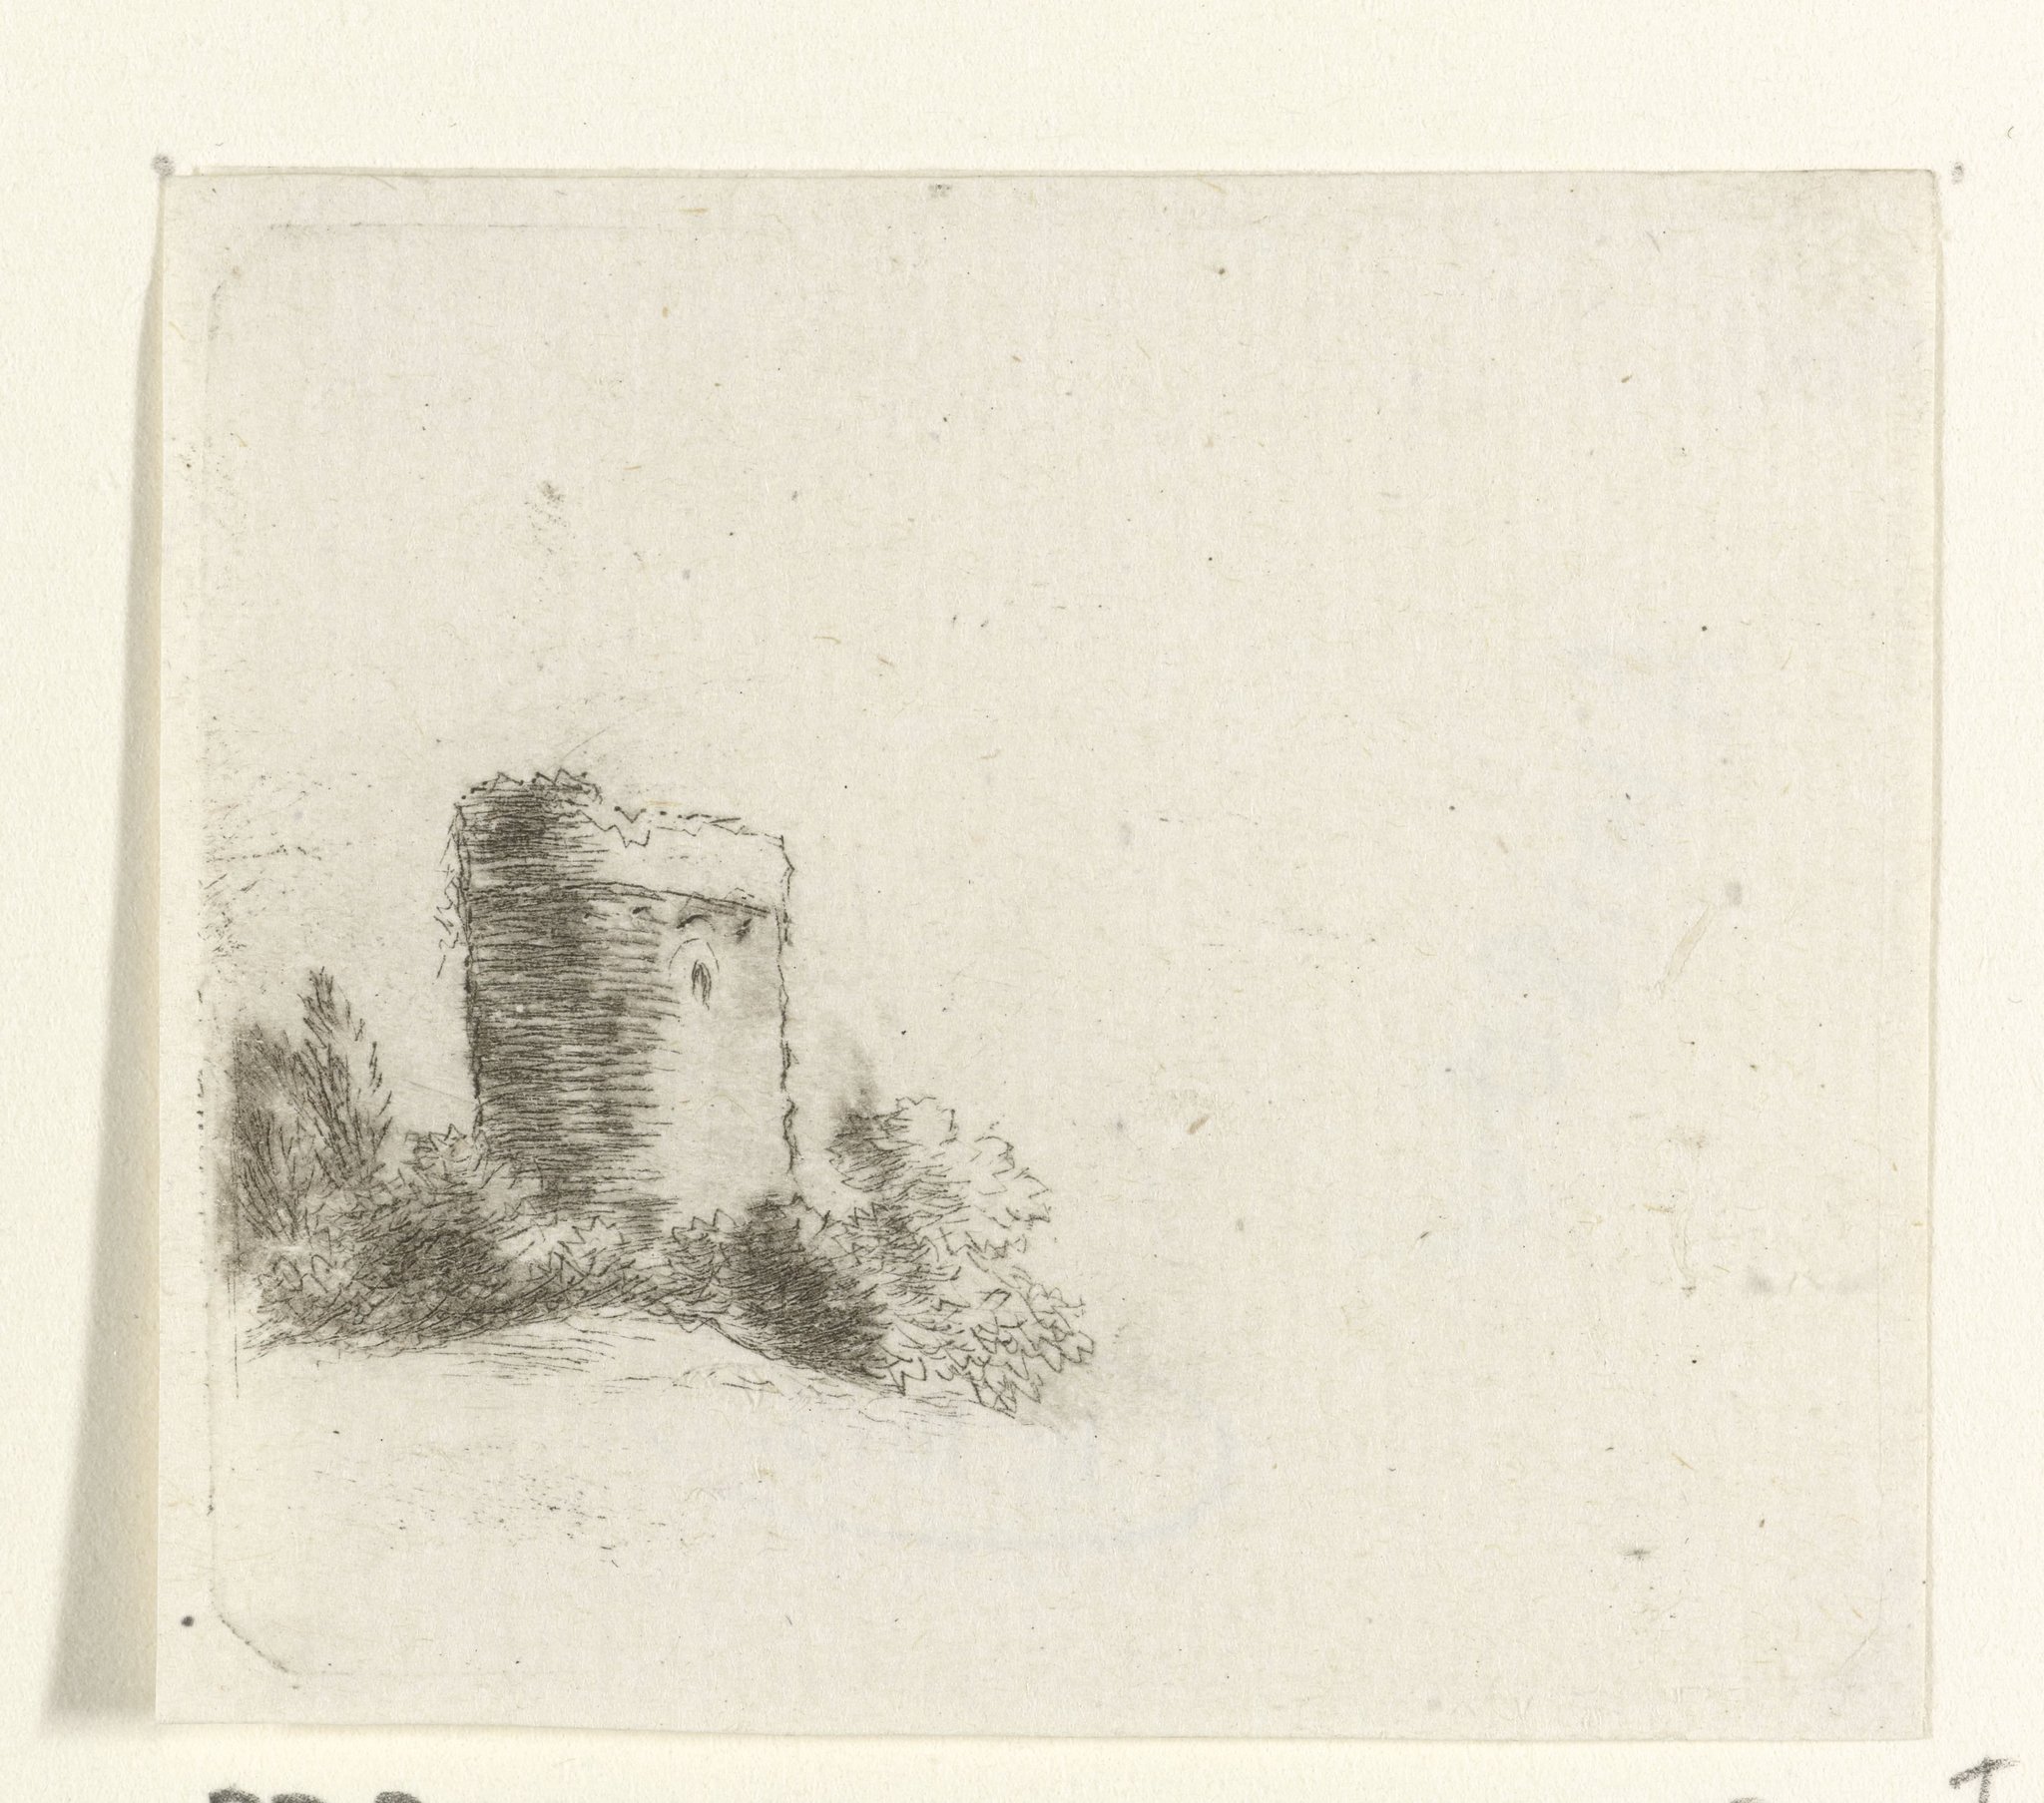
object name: print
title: Landschap met ronde toren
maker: johannes janson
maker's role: draughtsman, painter, print maker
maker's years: 1729-1784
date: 1761-1784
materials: paper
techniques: etching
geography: leiden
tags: landscape with tower or castle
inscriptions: collector's mark: Lugt 2228